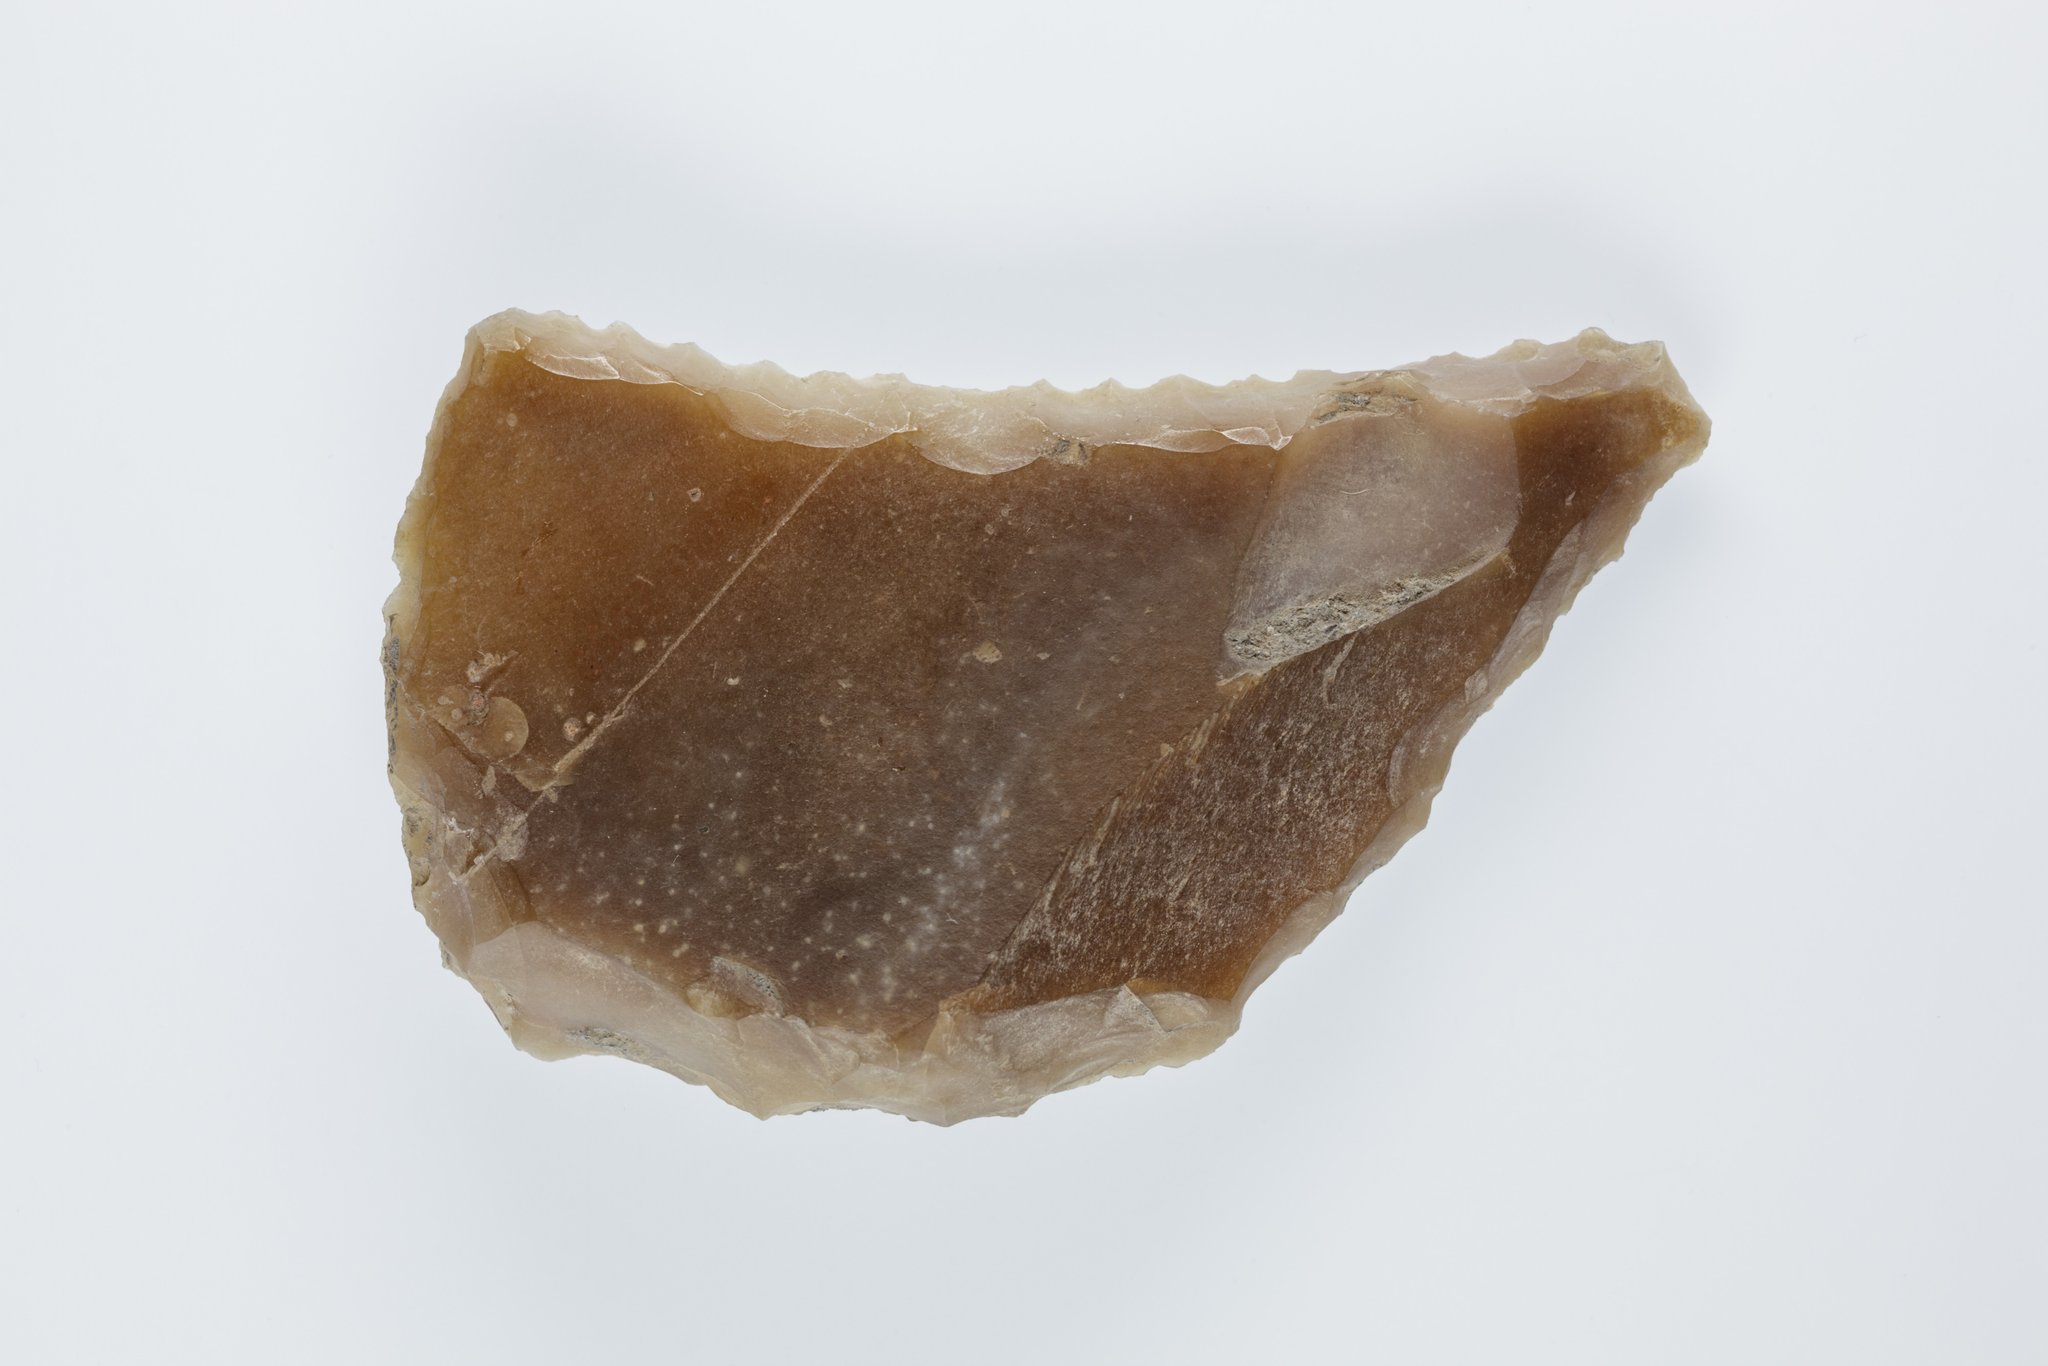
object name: sickle, denticulate, truncated, backed, geometric, tool, element, adhesive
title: Sickle Insert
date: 1186-1070 BCE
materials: stone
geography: egypt